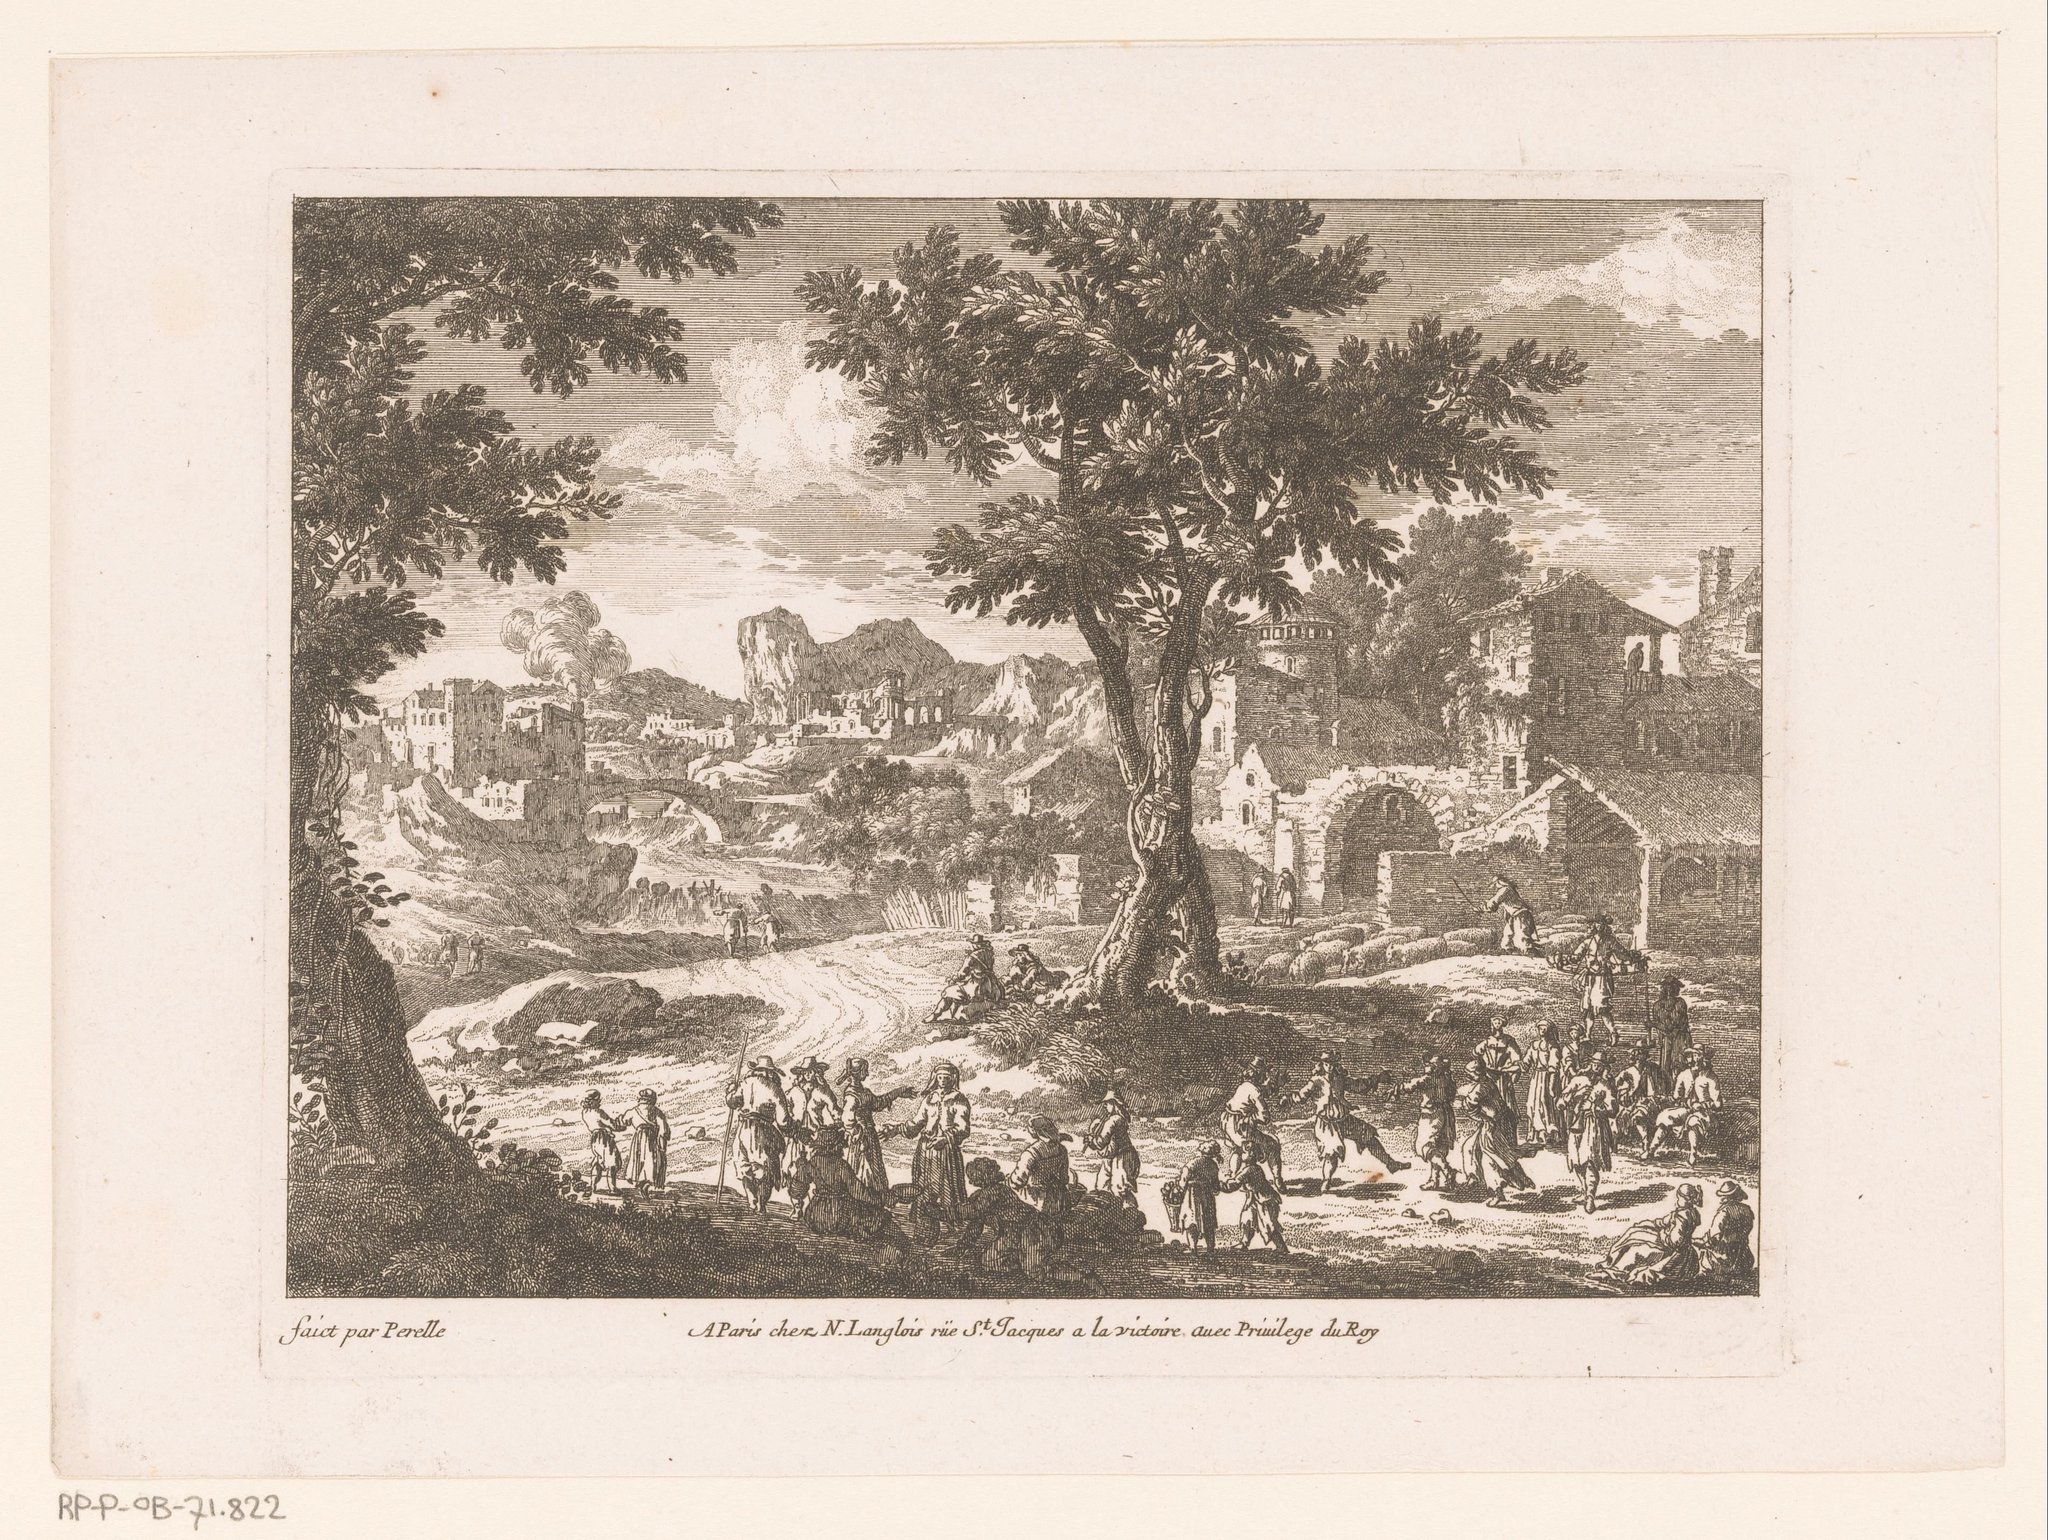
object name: print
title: Landschap met groep dansende en pratende mensen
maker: lodewijk xiv (koning van frankrijk)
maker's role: koning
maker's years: 1638-1715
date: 1650-1695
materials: paper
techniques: engraving, etching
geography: france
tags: landscapes (+ landscape with figures, staffage)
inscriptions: collector's mark: Lugt 240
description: Prenten met het signatuur 'Perelle' kunnen zowel door vader Gabriel als door zonen Nicolas en Adam gemaakt zijn.